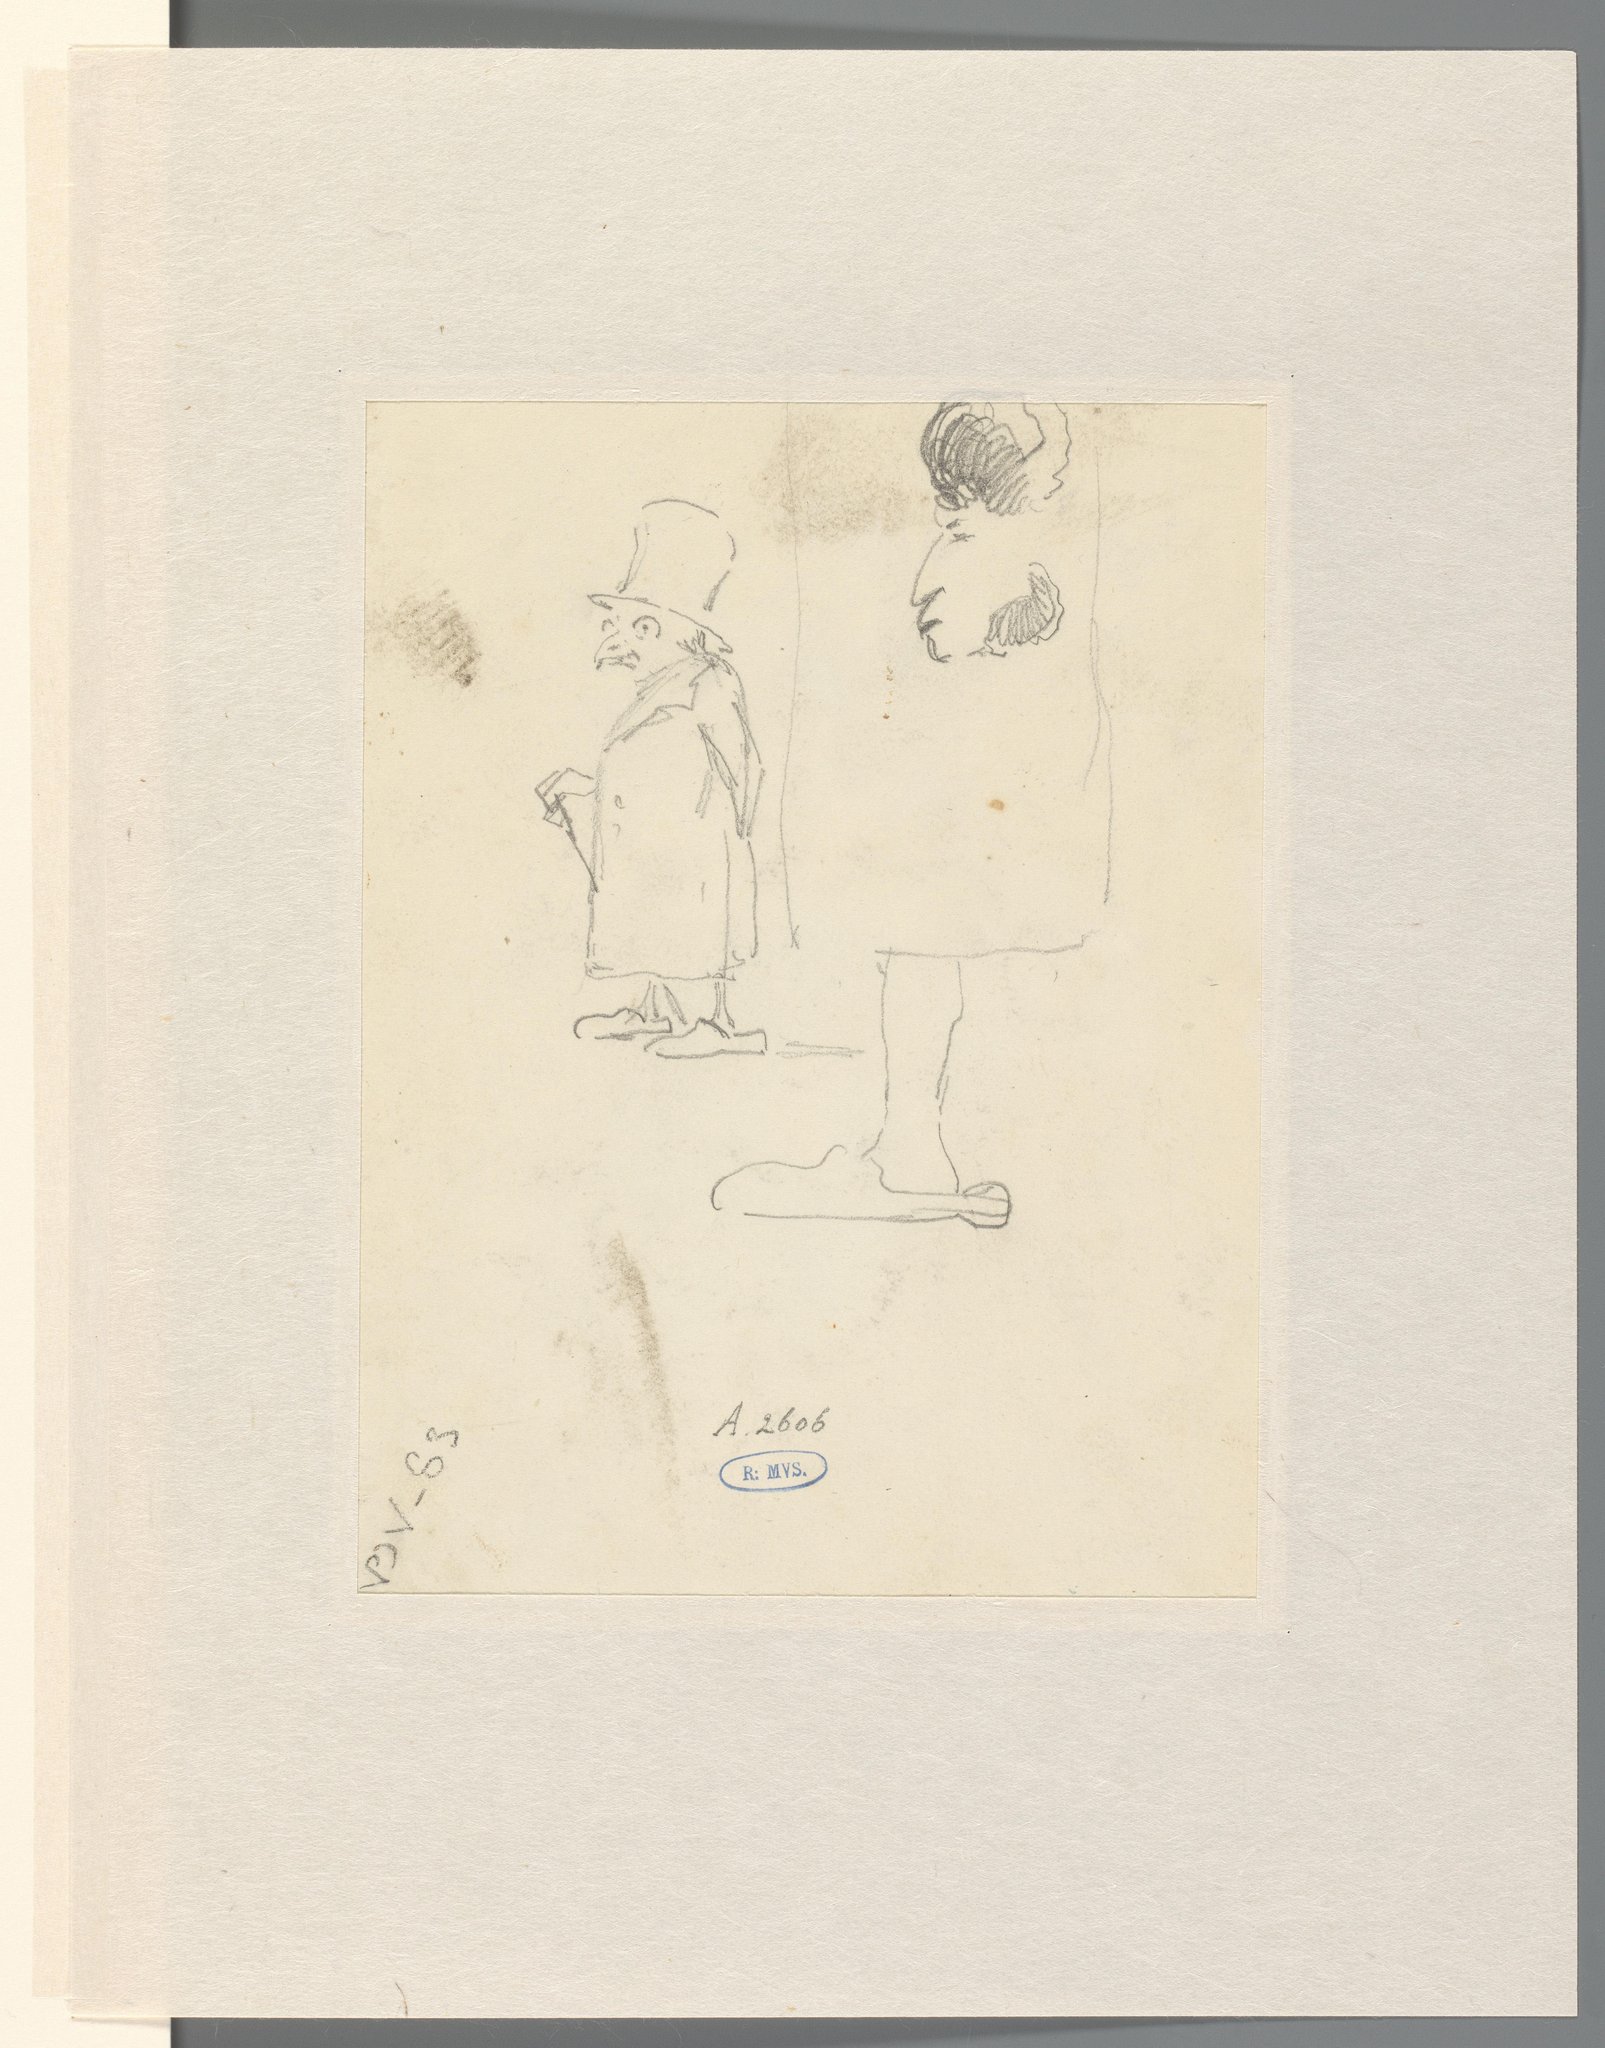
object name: schetsblad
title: Karikaturen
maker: johan daniël koelman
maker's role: draughtsman, print maker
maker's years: 1831-1857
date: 1841-1857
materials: paper, pencil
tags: caricatures (human types)